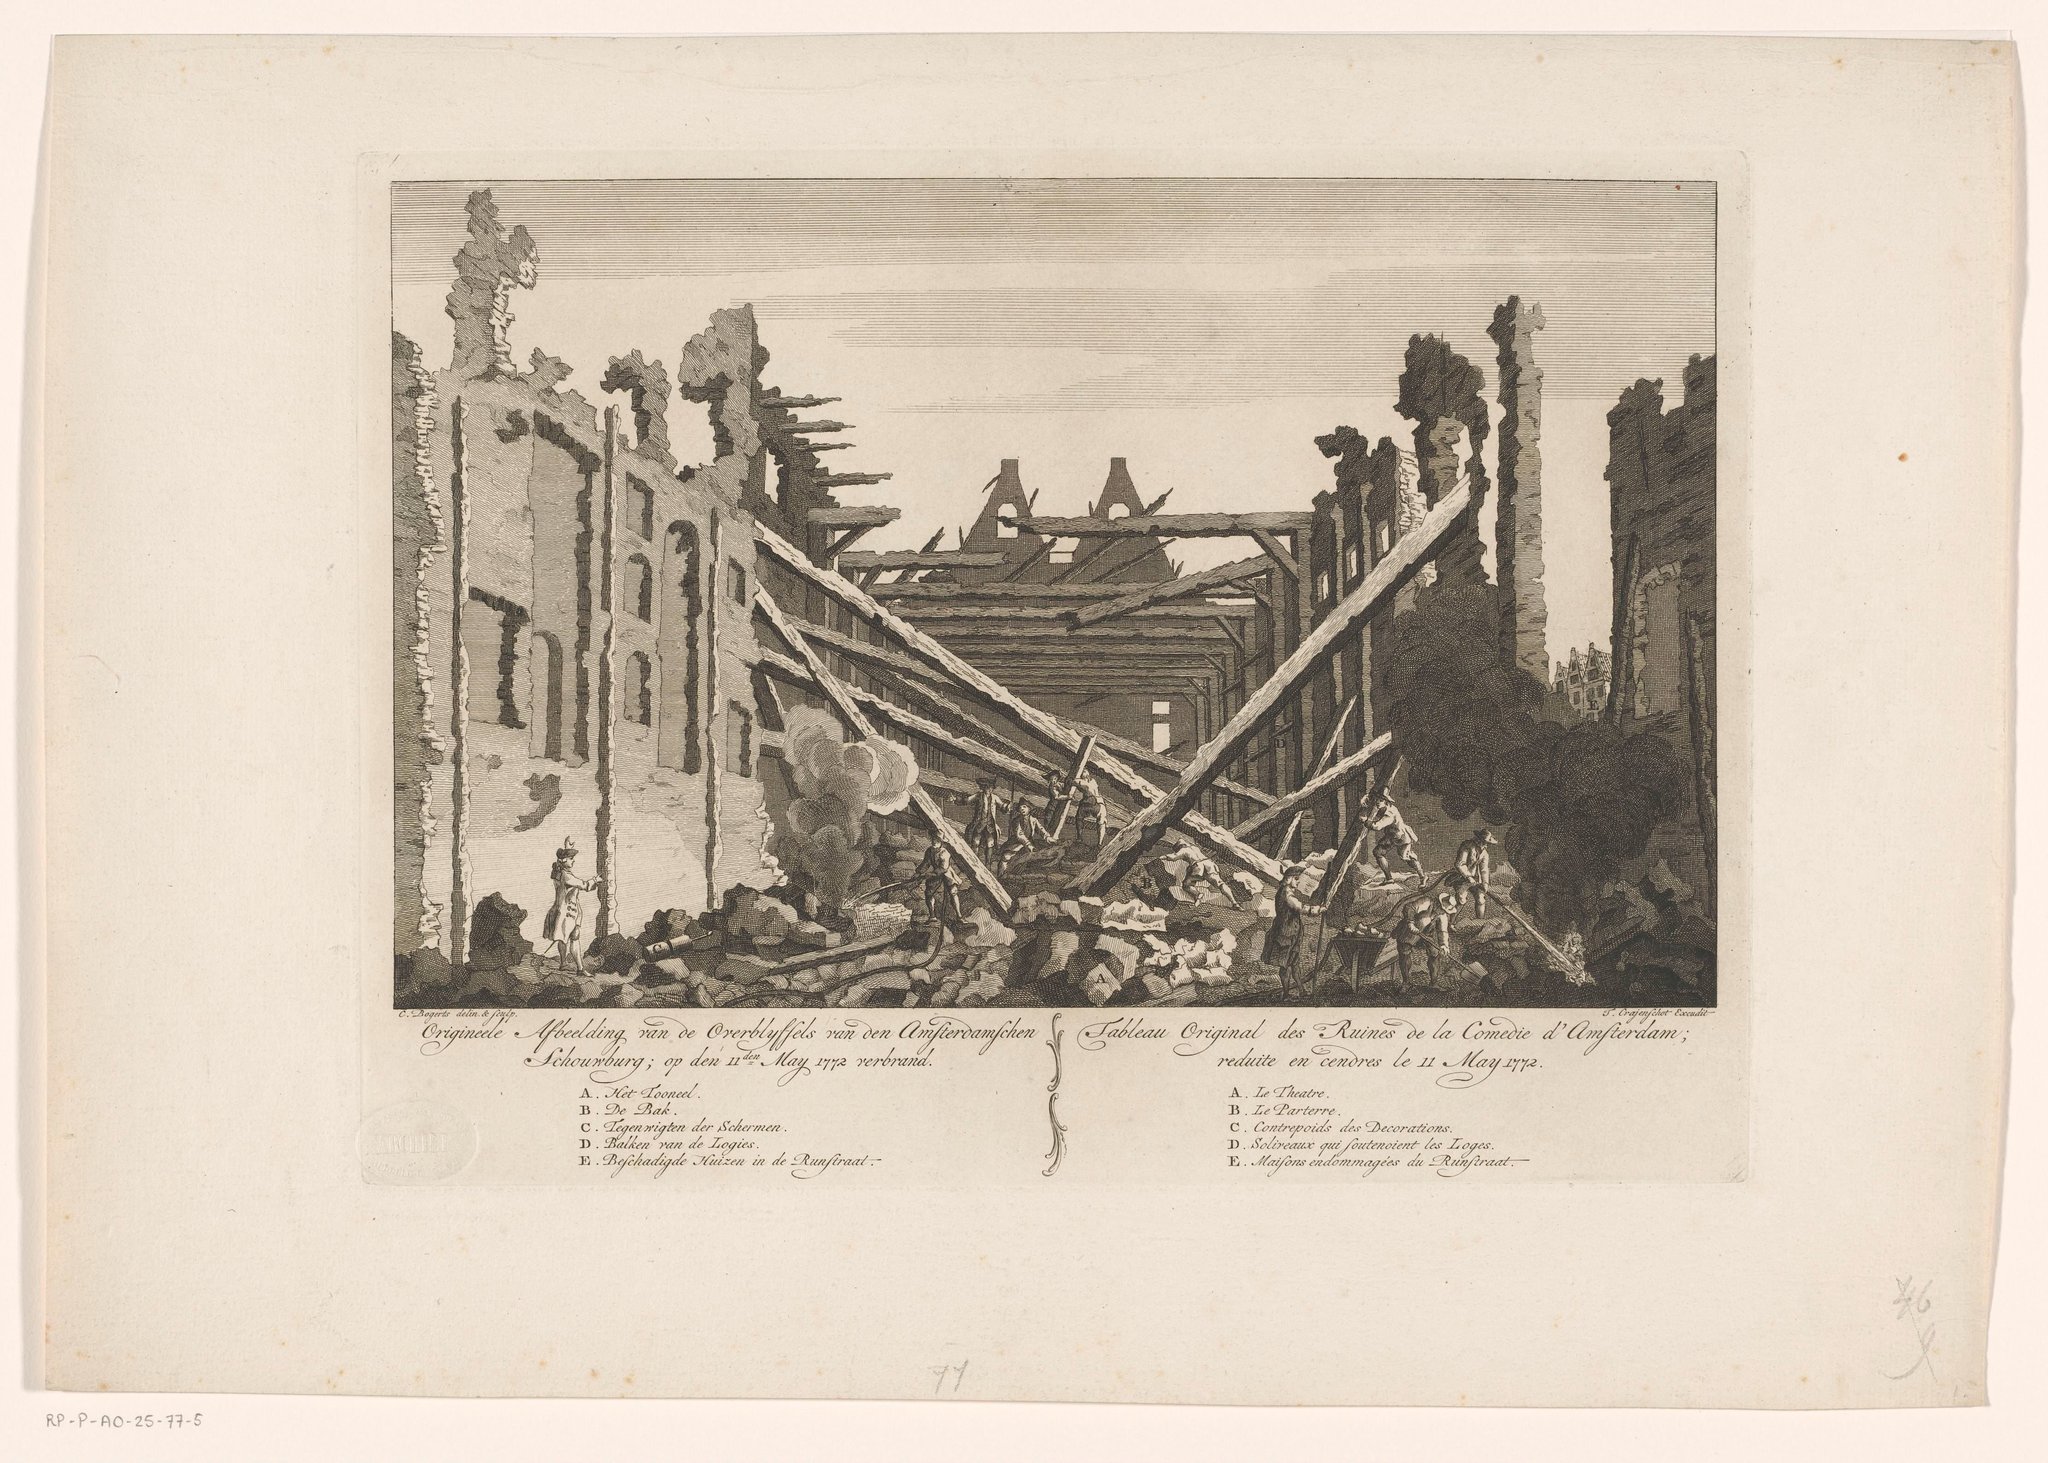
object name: print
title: De brand in de Amsterdamse Schouwburg, 1772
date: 1772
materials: paper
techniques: engraving, etching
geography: amsterdam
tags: on fire, ablaze, theatre, theatrical performance, ruin of a building ~ architecture, theatre (building), fire-fighting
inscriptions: check stamp: ‘Archief Ministerie van Oorlog Afdeeling Genie’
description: Gezicht op de ruïne van de Amsterdamse Schouwburg aan de Keizersgracht na de brand van 11 mei 1772. Brandweerlieden blussen met waterspuiten de laatste vuurhaarden, anderen ruimen puin. Onder de voorstelling de titel en legenda A-E in het Nederlands (links) en Frans (rechts). Onderdeel van een serie van vier prenten met titelprent over de brand in de Amsterdamse Schouwburg.